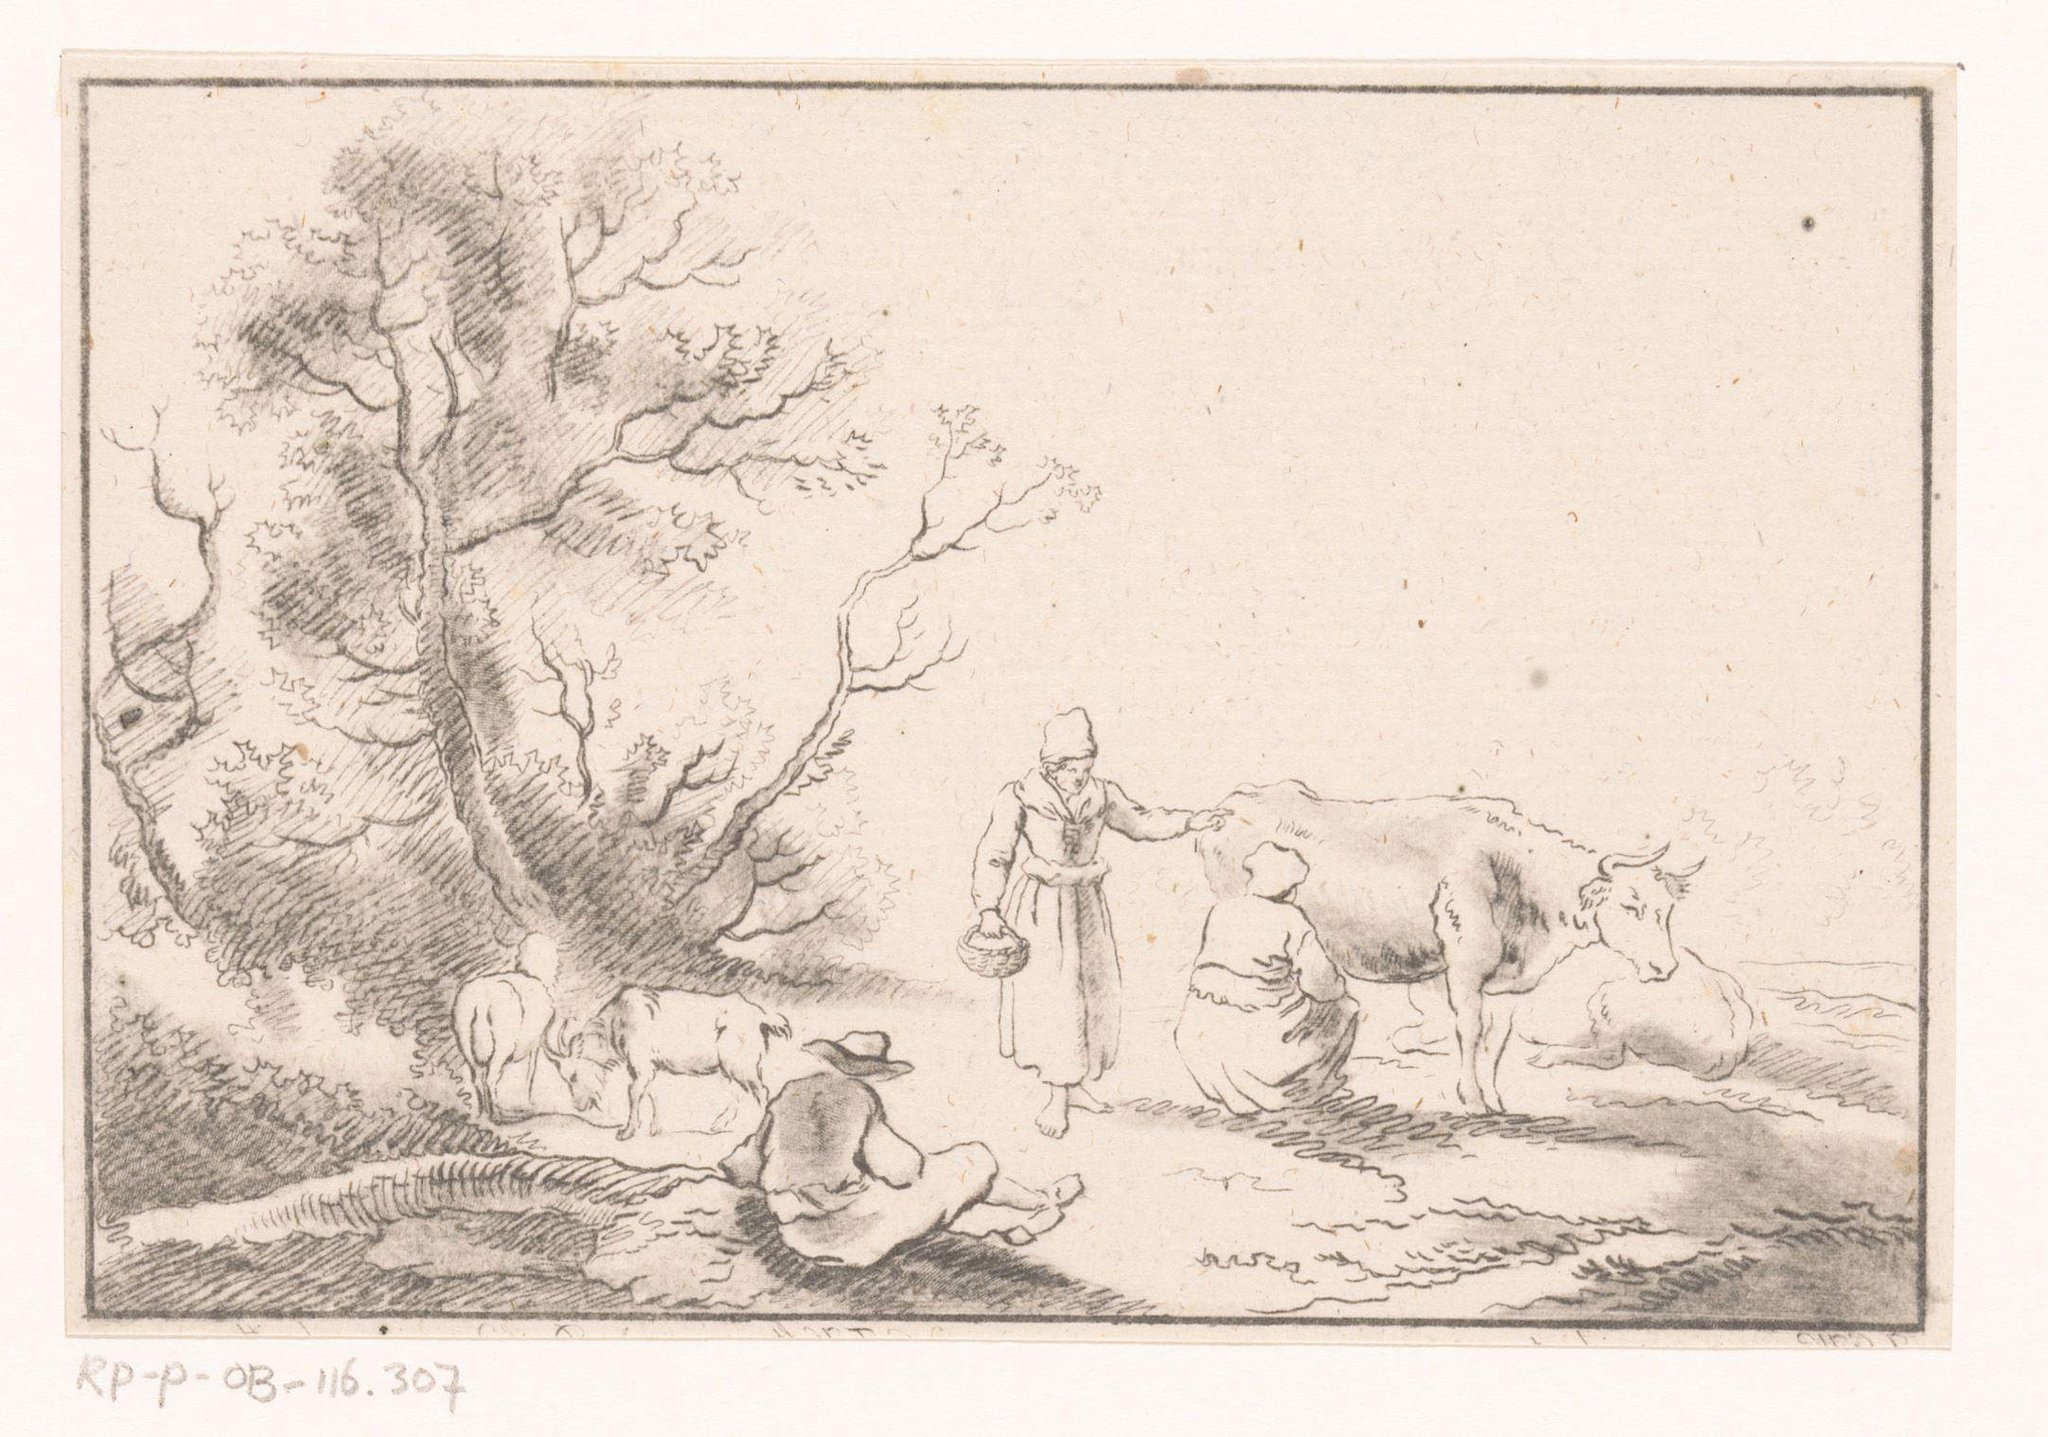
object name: print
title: Landschap met herders en runderen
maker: carl friedrich holtzmann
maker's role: print maker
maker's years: 1740-1811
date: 1750-1811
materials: paper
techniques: etching, intaglio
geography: dresden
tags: cattle, landscapes (+ landscape with figures, staffage), milking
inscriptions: collector's mark: Lugt 240